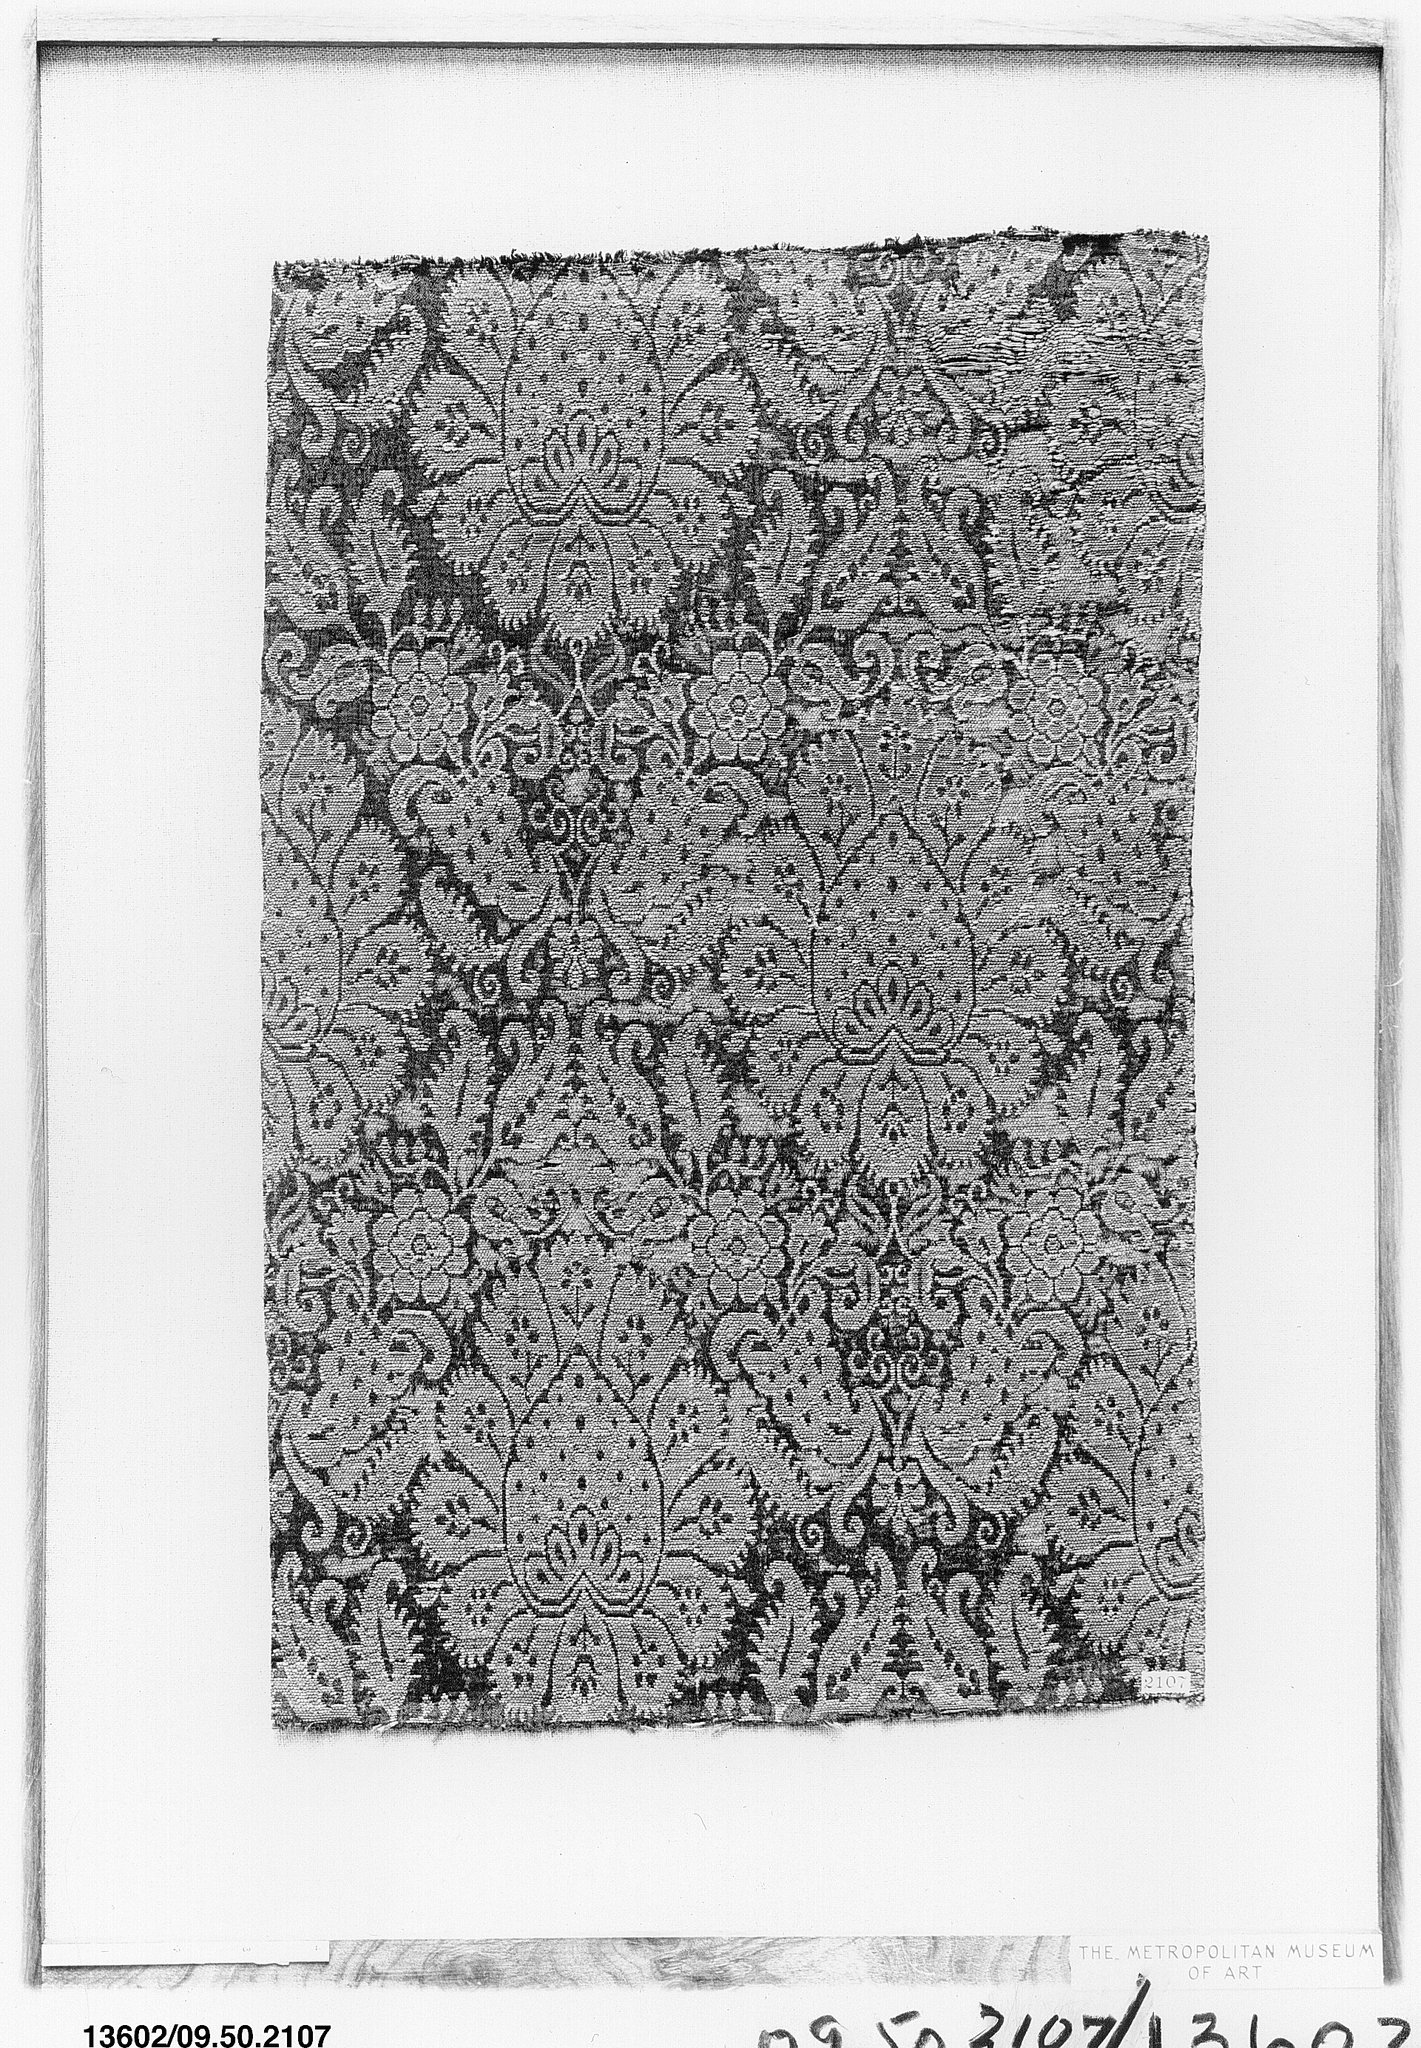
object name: piece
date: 1801-1900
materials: cotton, silk